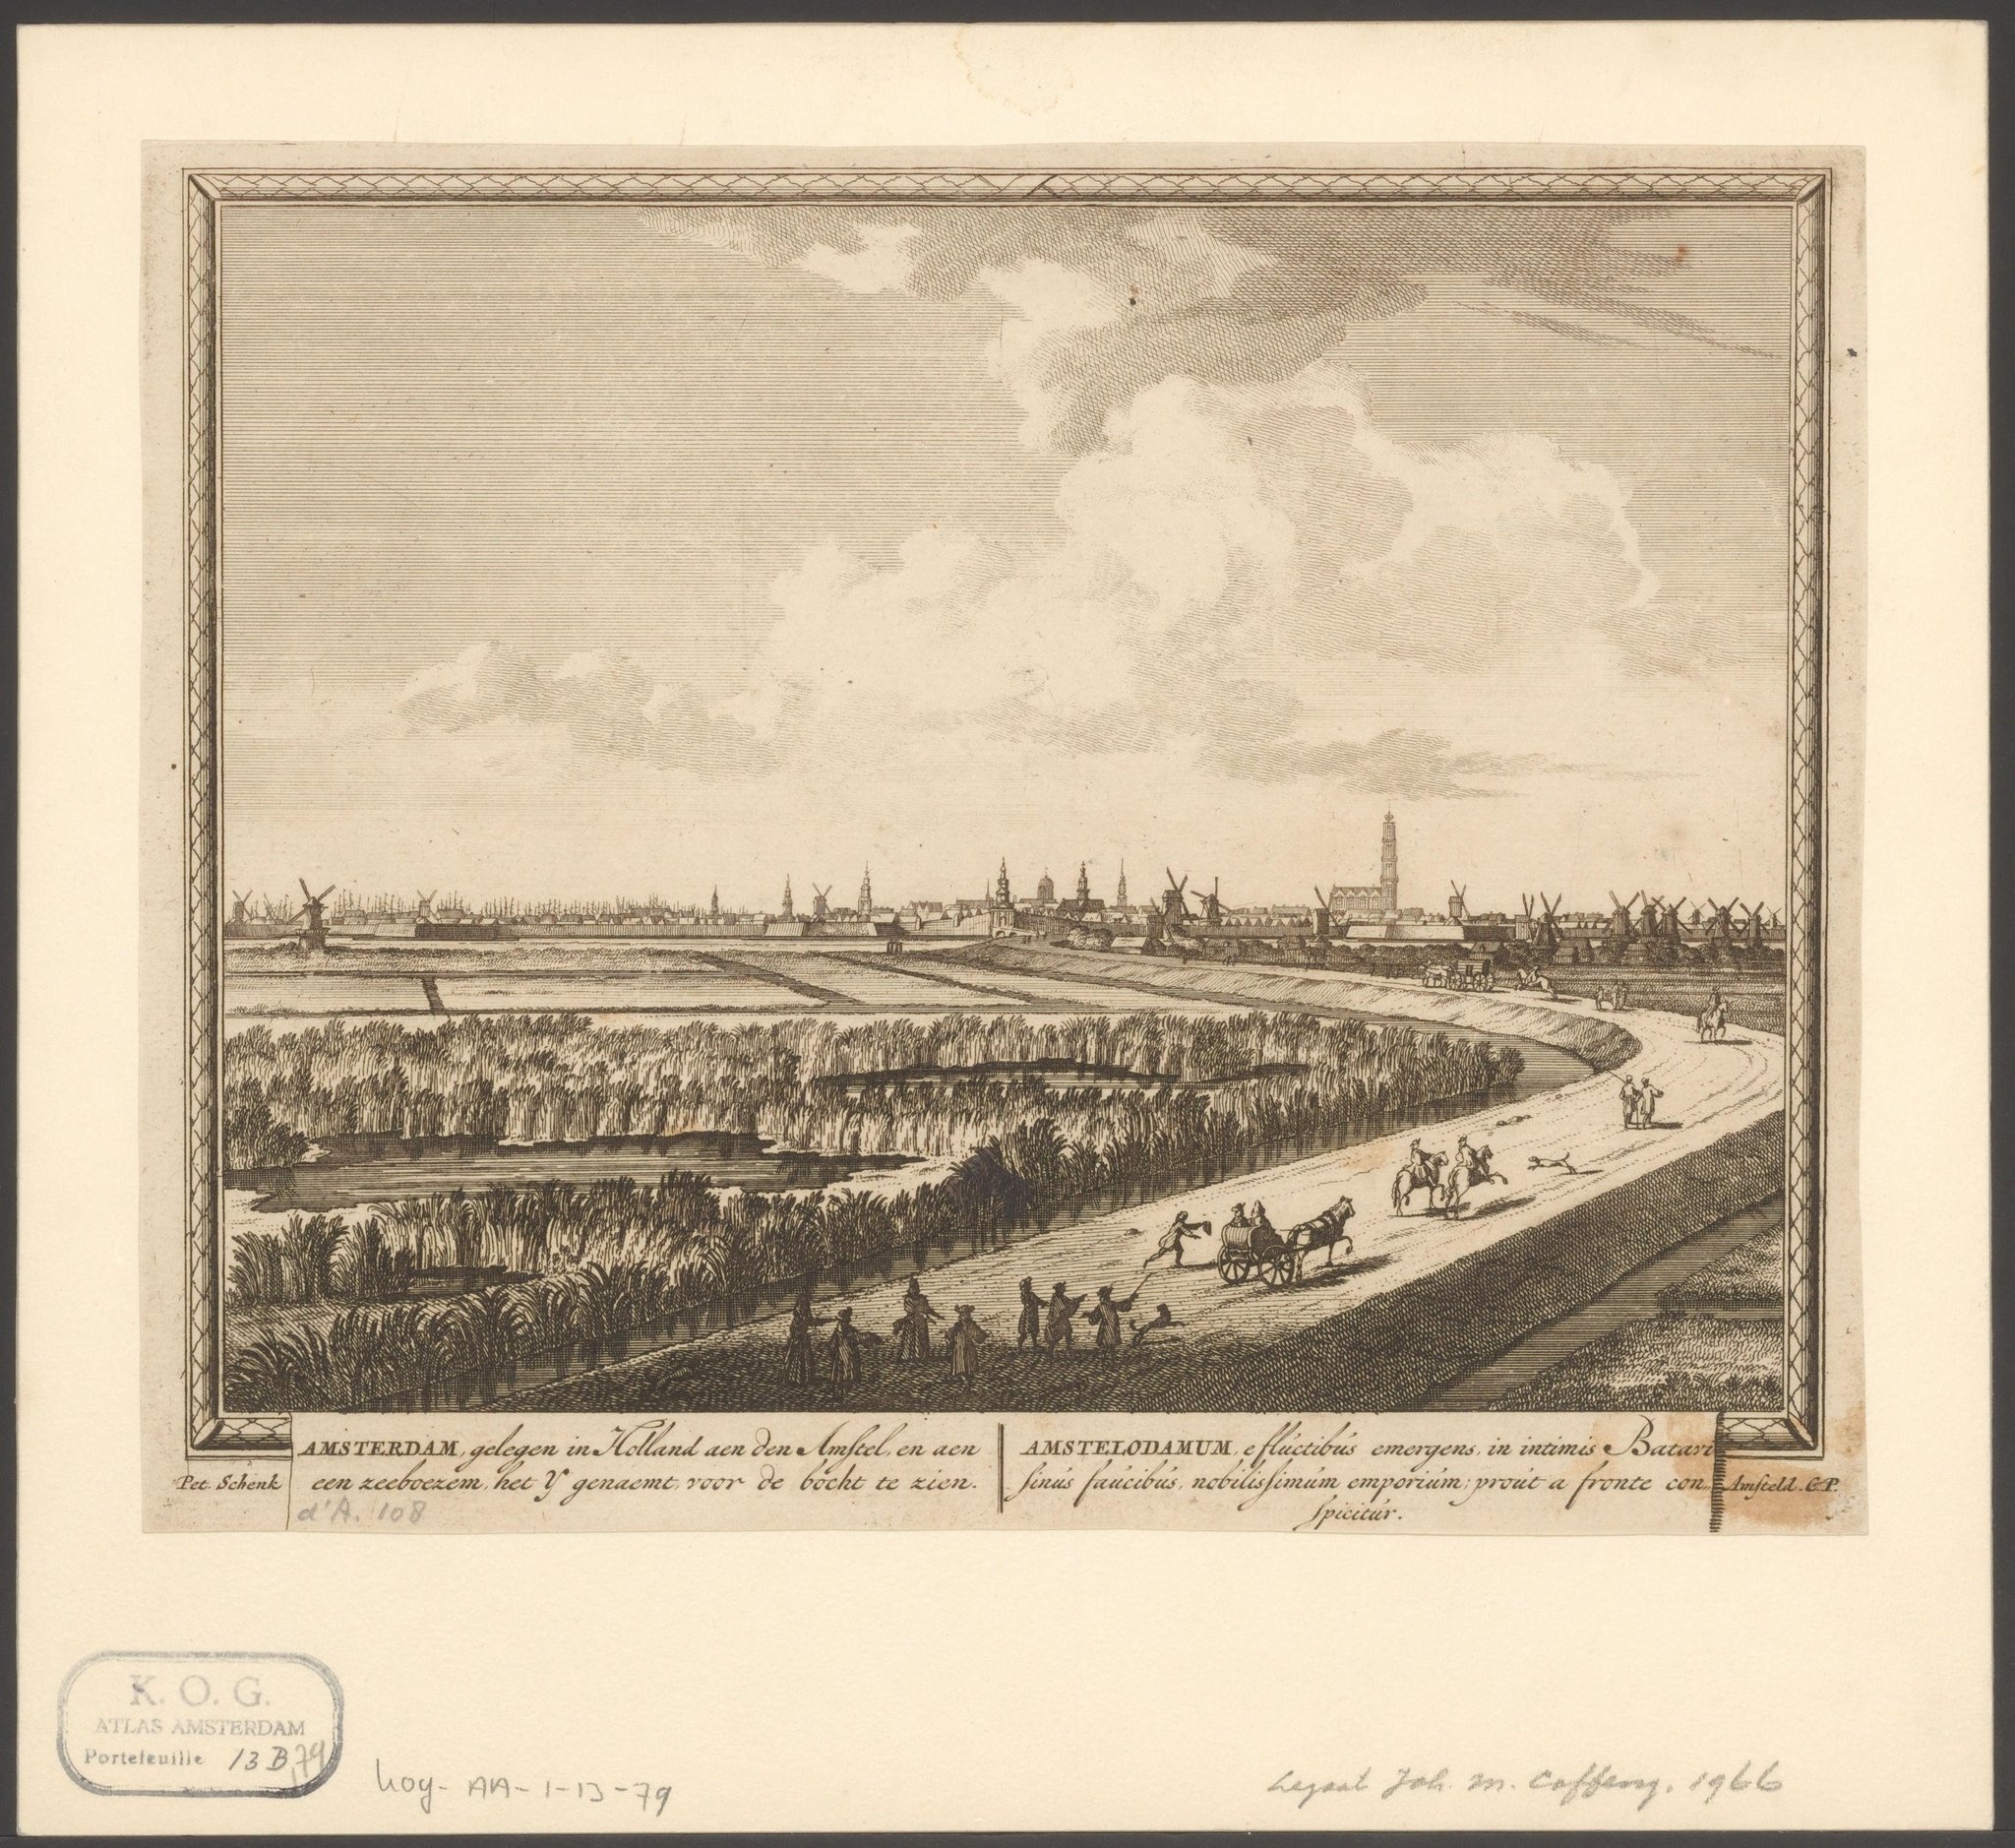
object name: print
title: Amsterdam, gelegen in Holland aen den Amstel, en aen een zeeboezem het Y genaemt, voor de bocht te zien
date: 1675-1711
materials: paper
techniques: etching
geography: amsterdam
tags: city-view in general; 'veduta', two-wheeled, animal-drawn vehicle, road, path, windmill in landscape, amsterdam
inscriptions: inscription: ‘Legaat Joh. M. Coffeng. 1966’, collector's mark: ‘13B,79’ Lugt 1641b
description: Onderwerpsrubriek binnen de Atlas Amsterdam: Slatuinenpad, Sloterkade, Slootstraat, Slijkstraat, Snoekjesgracht, Sophiapark, Spaarndammerdijk, Spiegelgracht, Spinhuissteeg, Spui, Spuistraat (ook lage Erf), Staalstraat, Stadhouderskade, Steenpad, Stroomarkt.